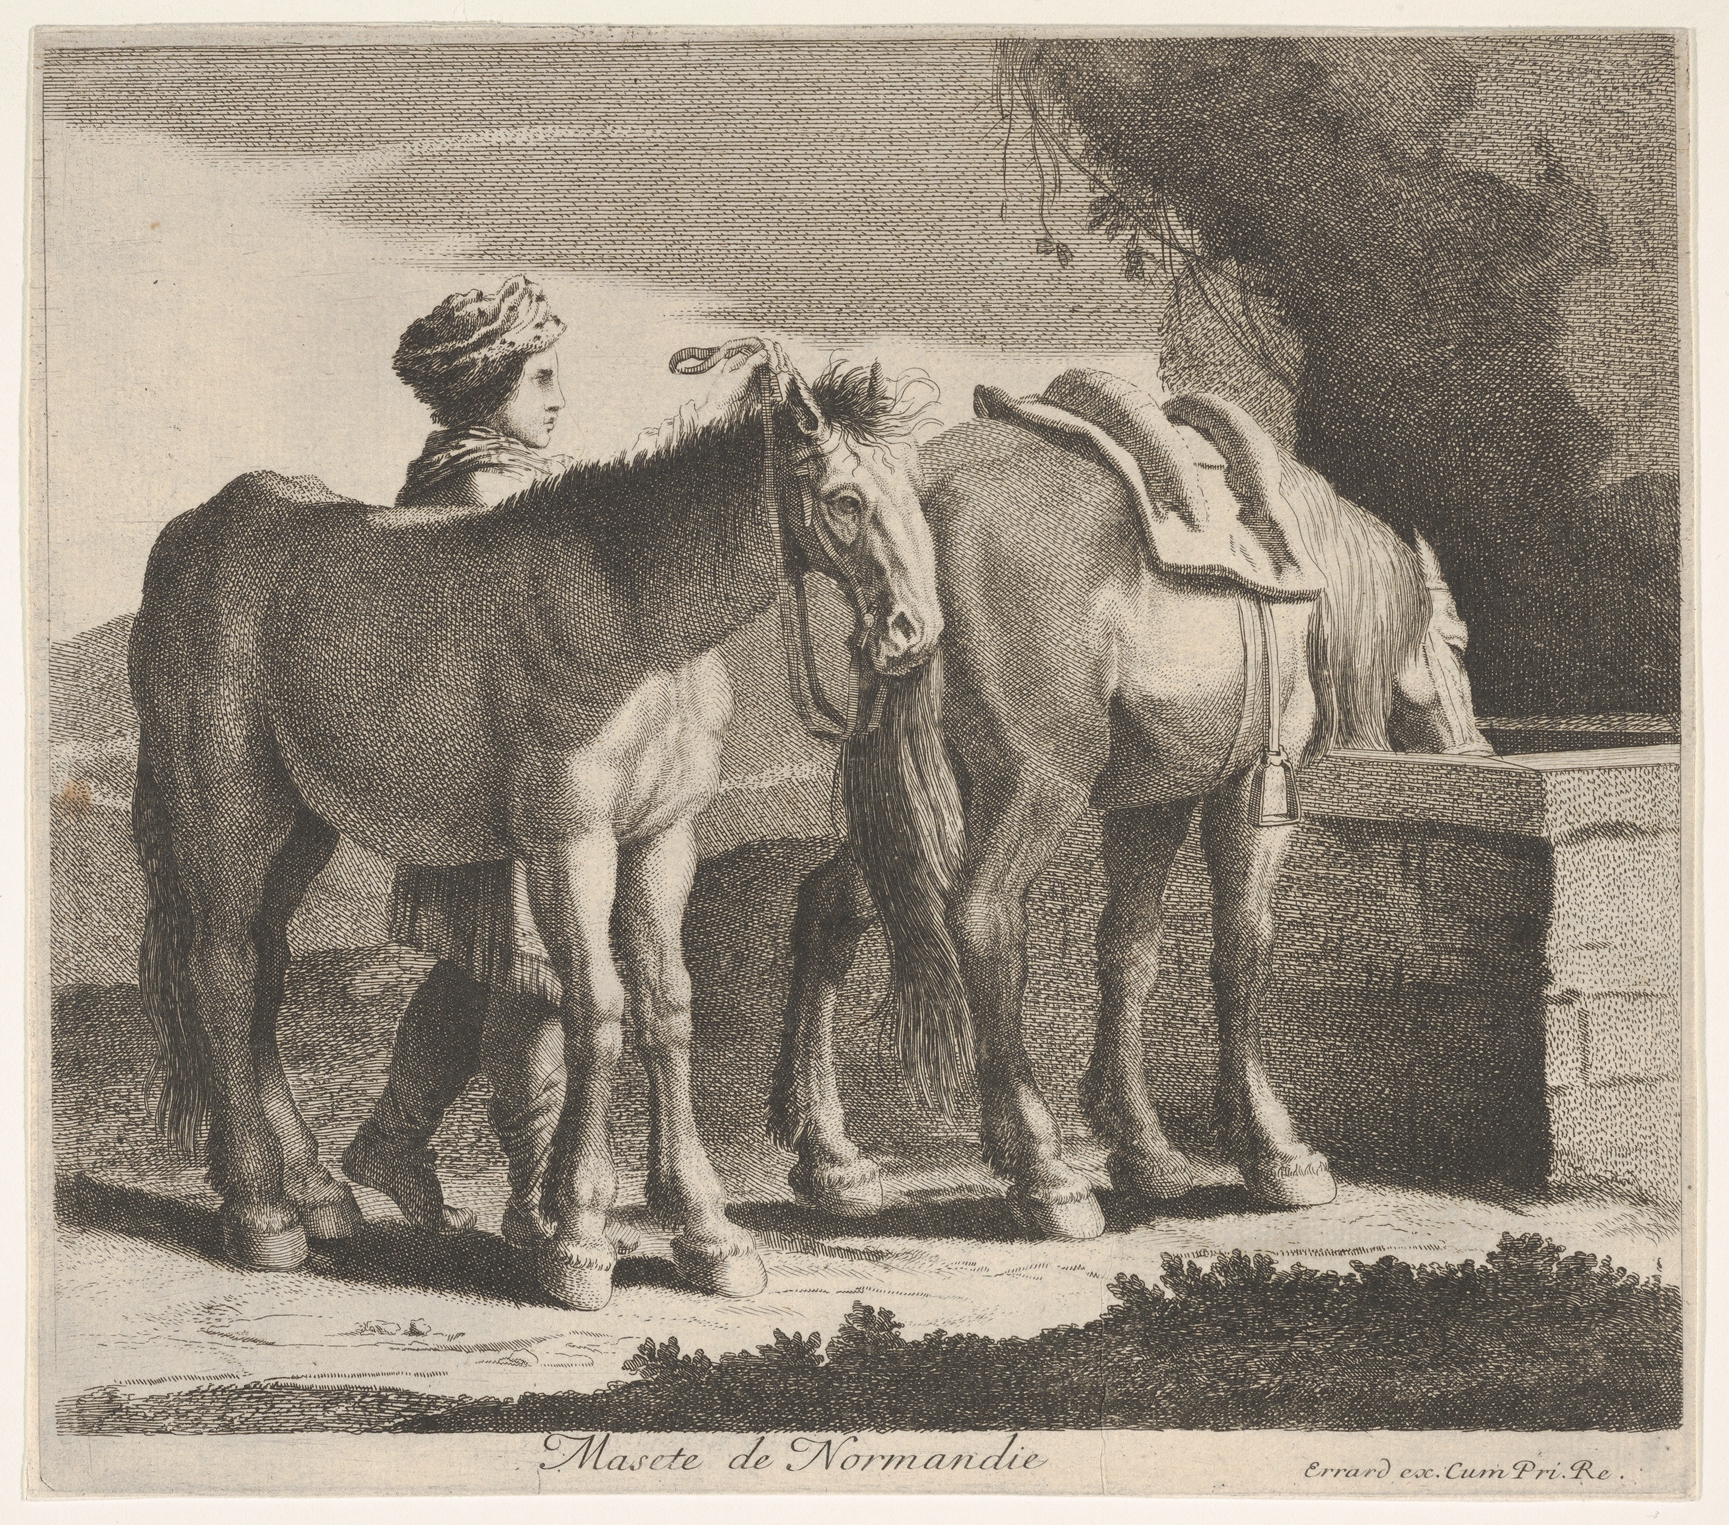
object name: print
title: Masete de Normandie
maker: charles errard le fils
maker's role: artist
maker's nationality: french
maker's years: 1606-1689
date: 1606-1689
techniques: engraving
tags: horses